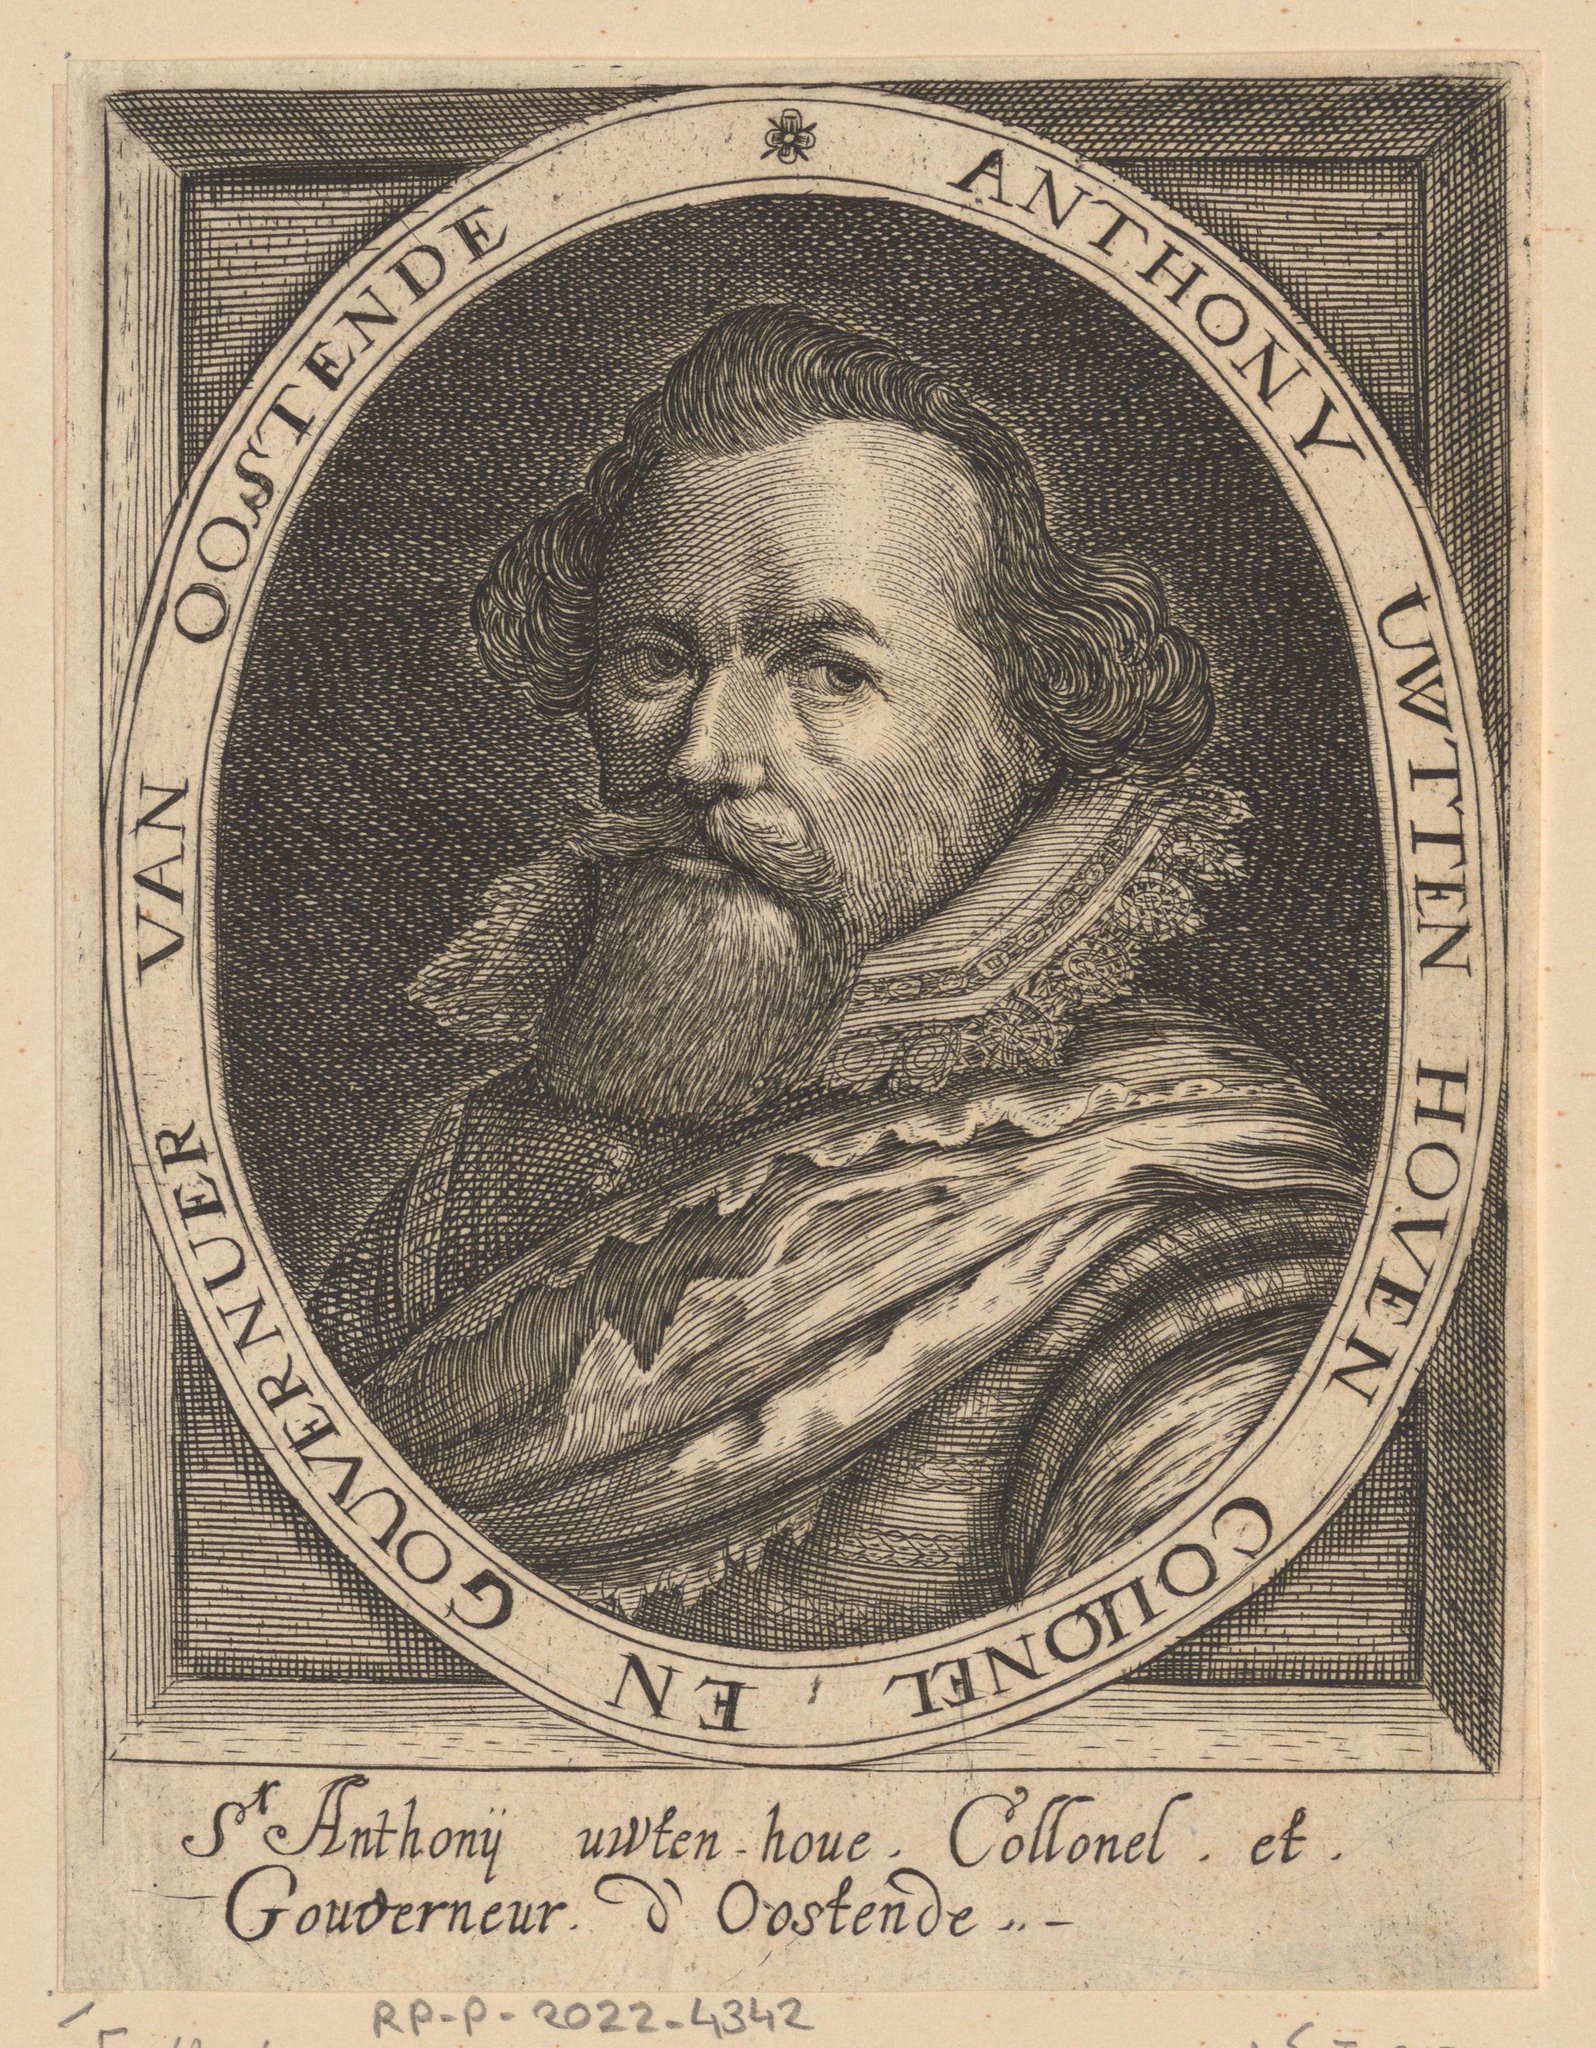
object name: print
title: Portret van Anthony Uyttenhoven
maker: Anonymous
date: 1621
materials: paper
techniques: engraving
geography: northern netherlands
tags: historical persons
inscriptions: collector's mark: Lugt 964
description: Prent waarschijnlijk uit: Fleming, Philippe. Oostende vermaerde, gheweldighe lanckduyrighe ende bloedighe belegheringhe, bestorminghe ende stoute aenvallen (...) Den Haag: Aert Meuris, 1621.